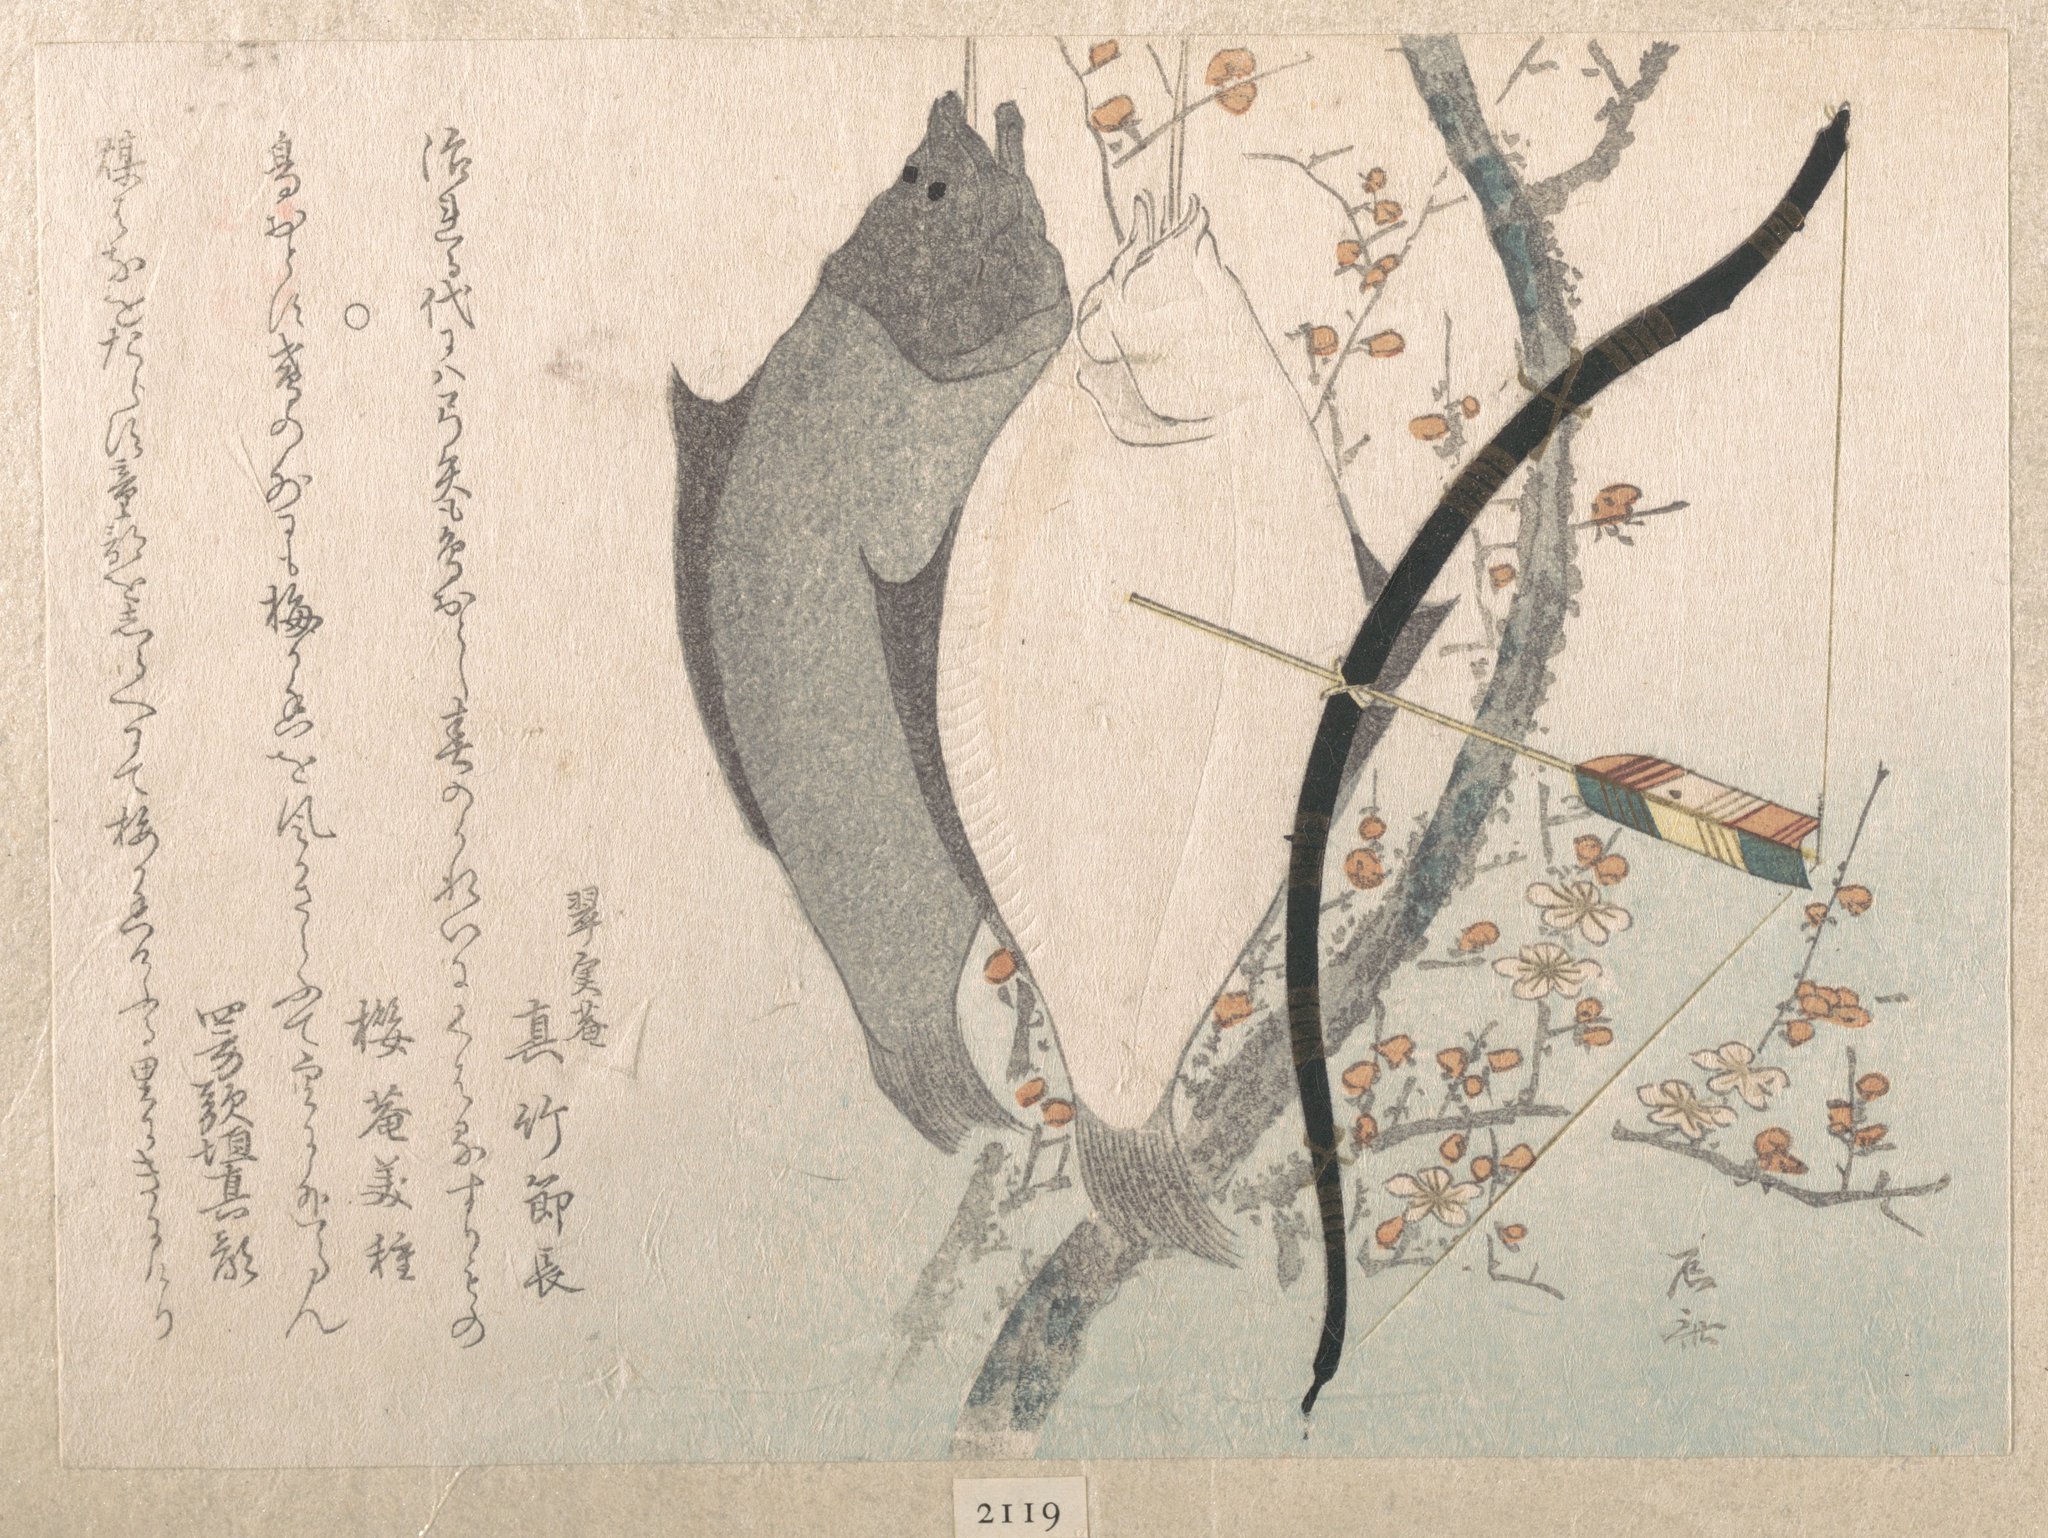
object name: print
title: Halibuts and a Bow with Arrow Hanging on a Plum Tree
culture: japanese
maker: ryūryūkyo shinsai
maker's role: artist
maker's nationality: japanese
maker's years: 1799-1823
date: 1801-1900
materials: ink, paper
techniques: surimono, woodblock print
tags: bow and arrow,fish,trees